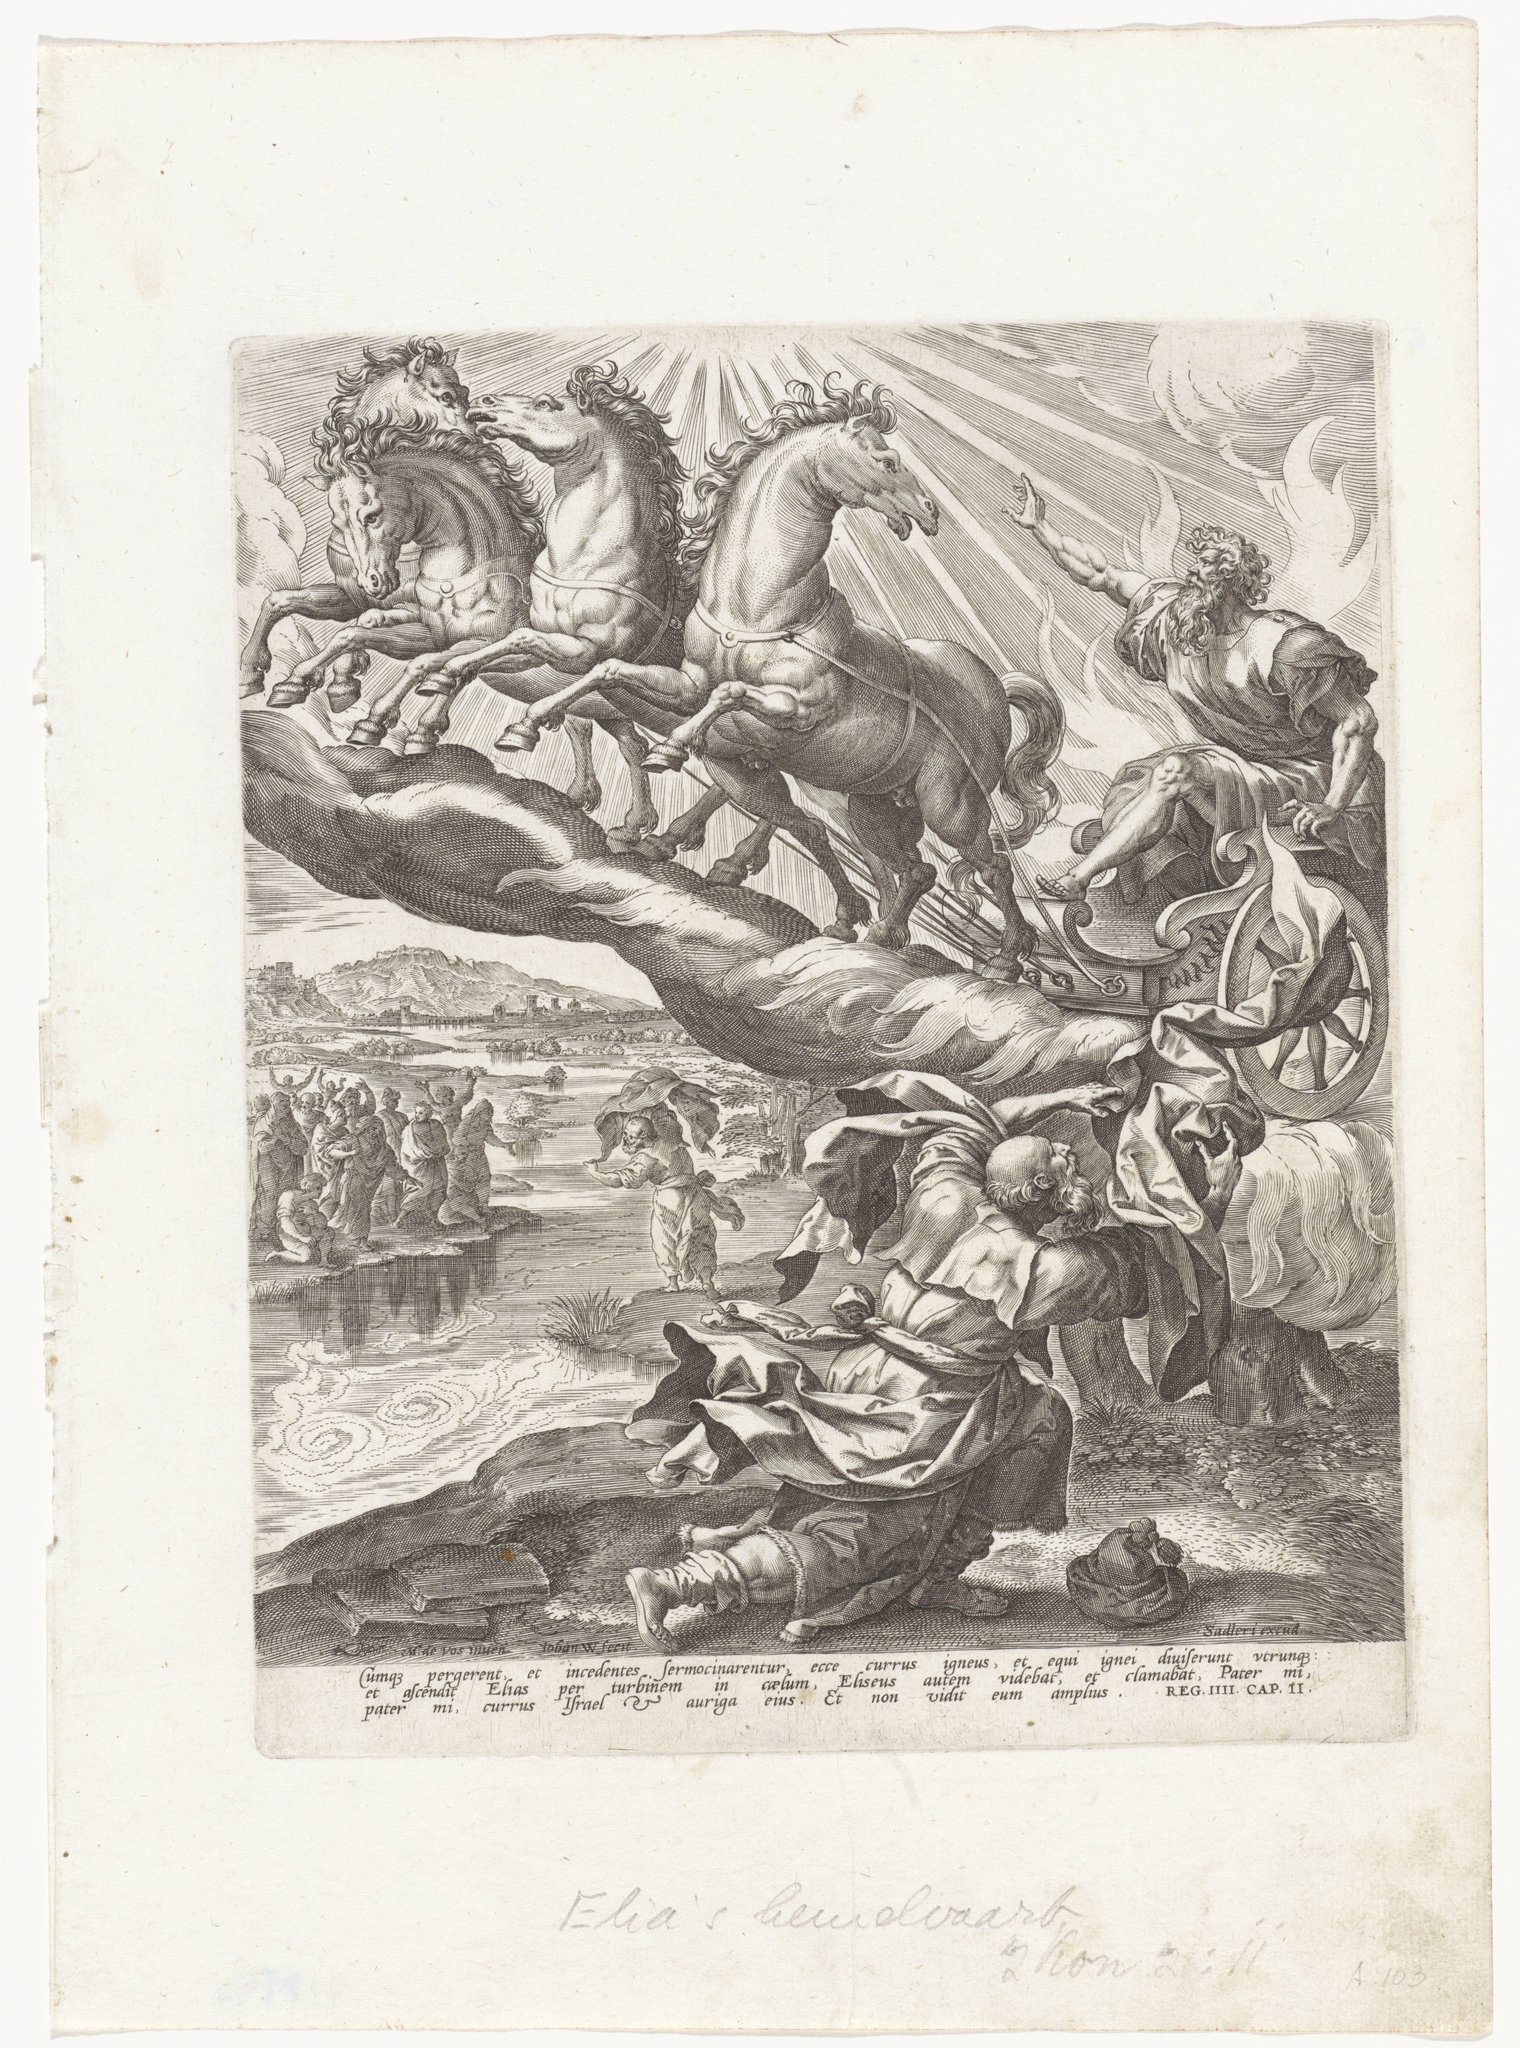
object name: print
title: Hemelvaart van Elia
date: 1582-1583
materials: paper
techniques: engraving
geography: antwerp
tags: elisha strikes the water with elijah's cloak, parts the water and recrosses the river; he thus wins recognition from the sons of the prophets, a chariot, horses of fire and a whirlwind appear and elijah is carried up into heaven; elijah's cloak falls (or he hands it over to elisha)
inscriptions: collector's mark: Lugt 2228, caption: ‘Cumq pergerent, et incedentes,.....eum amplius. REG. IIII. CAP.11’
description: Elia wordt in een wagen van vuur, met paarden ervoor, meegevoerd naar de hemel. Elisa vangt nog net diens mantel. Op de achtergrond is te zien hoe Elisa vervolgens met de mantel van Elia op het water slaat zodat het naar links en rechts stroomt en hij de rivier kan oversteken. Daarmee wint hij de erkenning van de profeten aan de overkant. In de marge een drieregelig Bijbelcitaat uit 2 Kon. 2 in het Latijn.